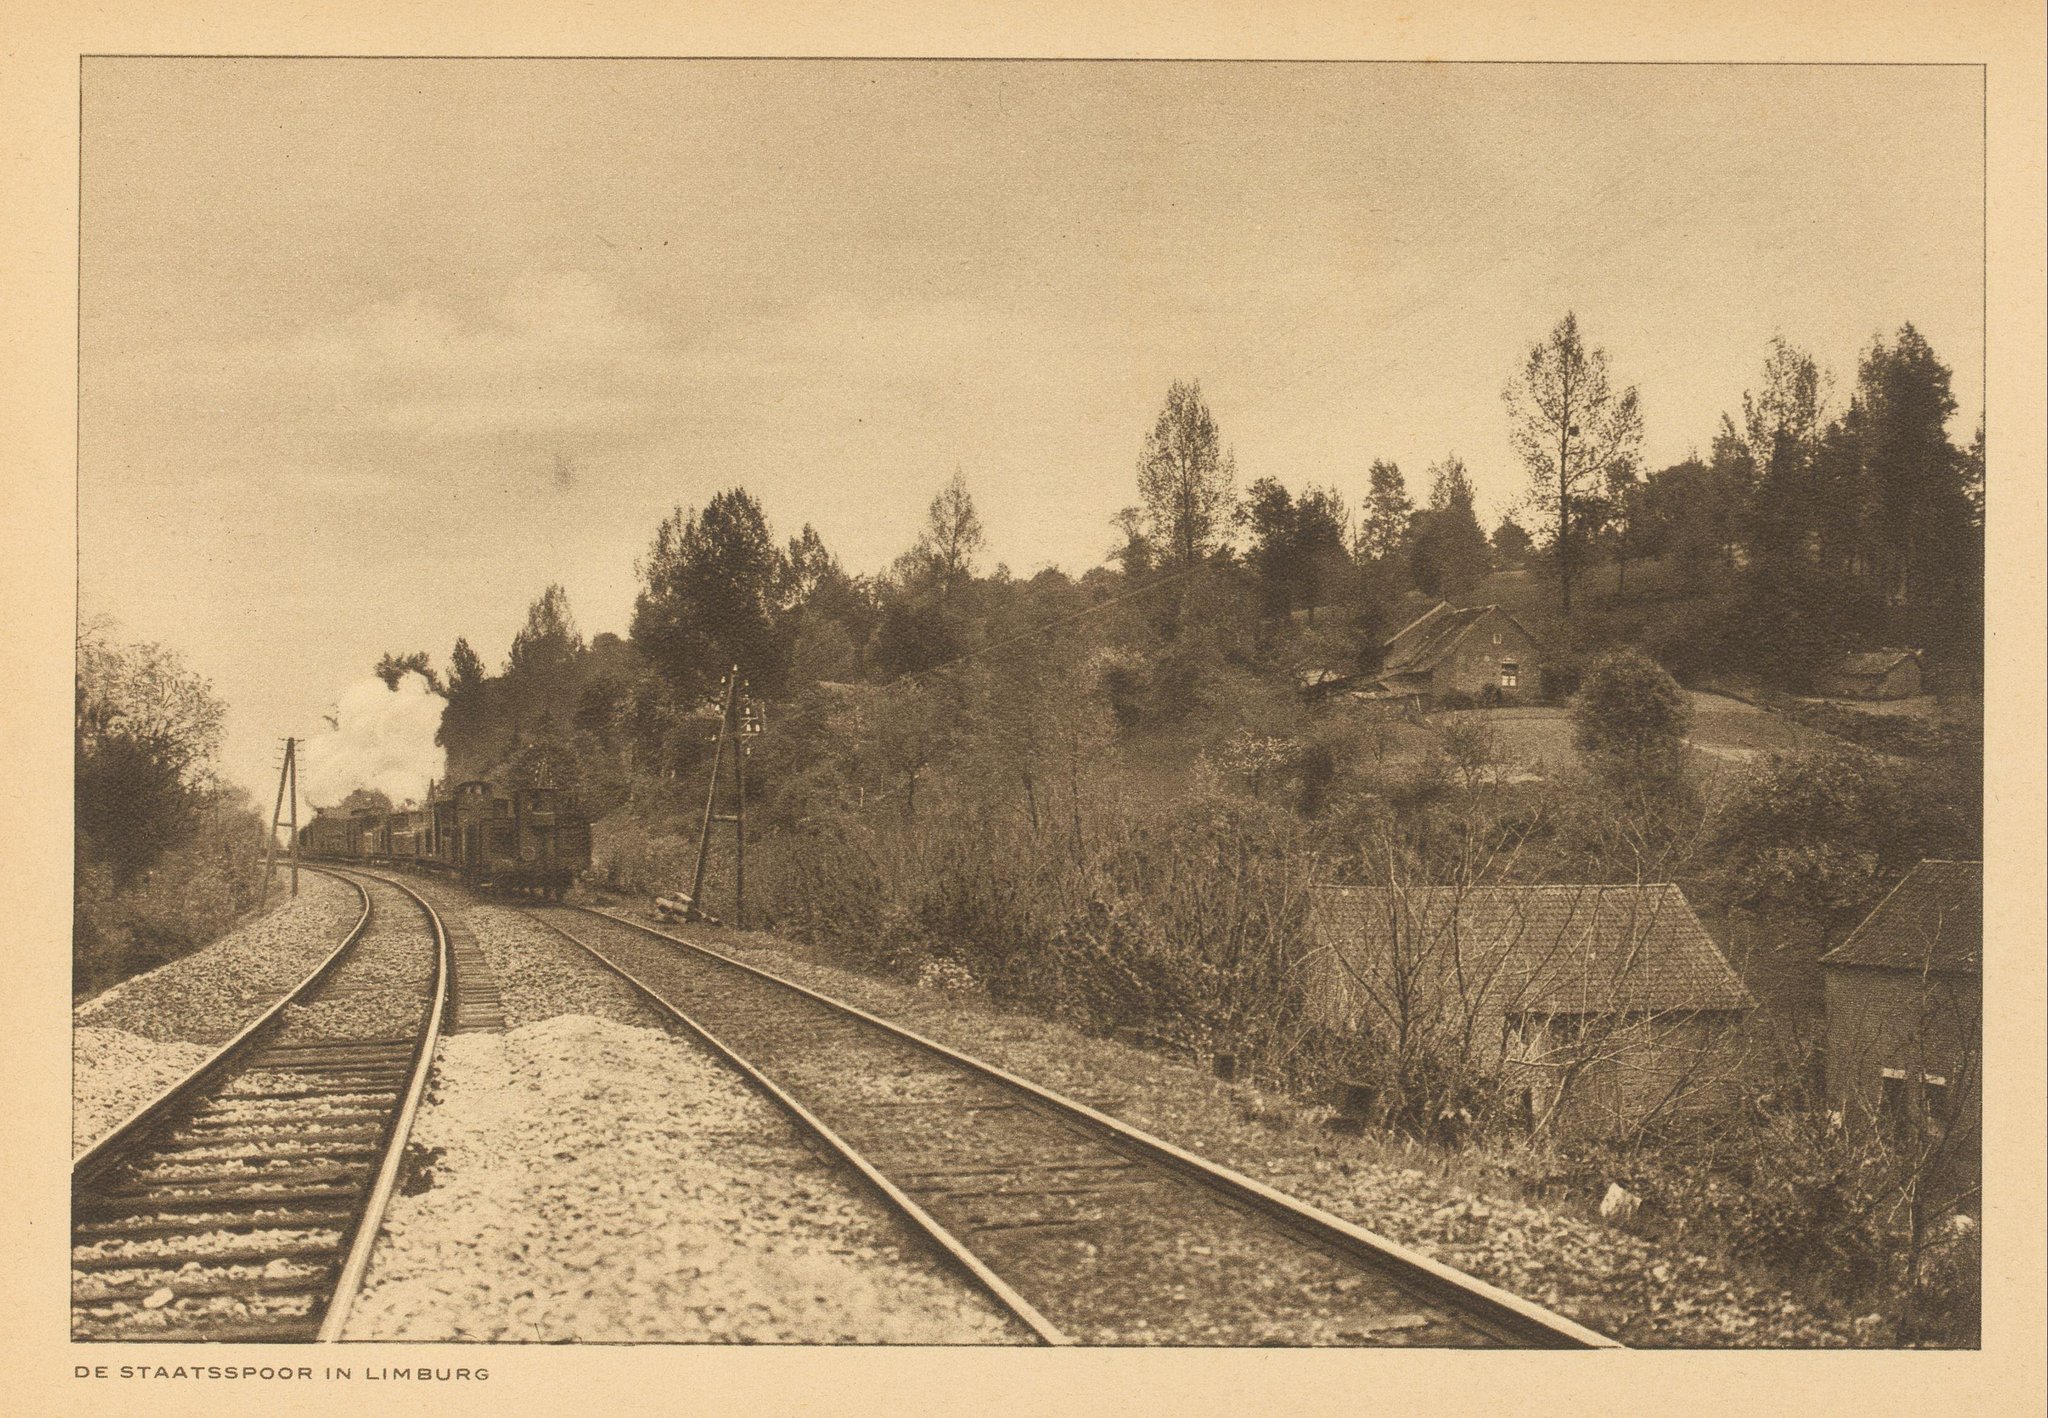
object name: album leaf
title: Trein van de Staatsspoorwegen op het spoor in Limburg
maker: Anonymous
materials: paper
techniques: rotogravure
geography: limburg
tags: low hill country, railway, train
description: Deze prent maakt deel uit van een album.